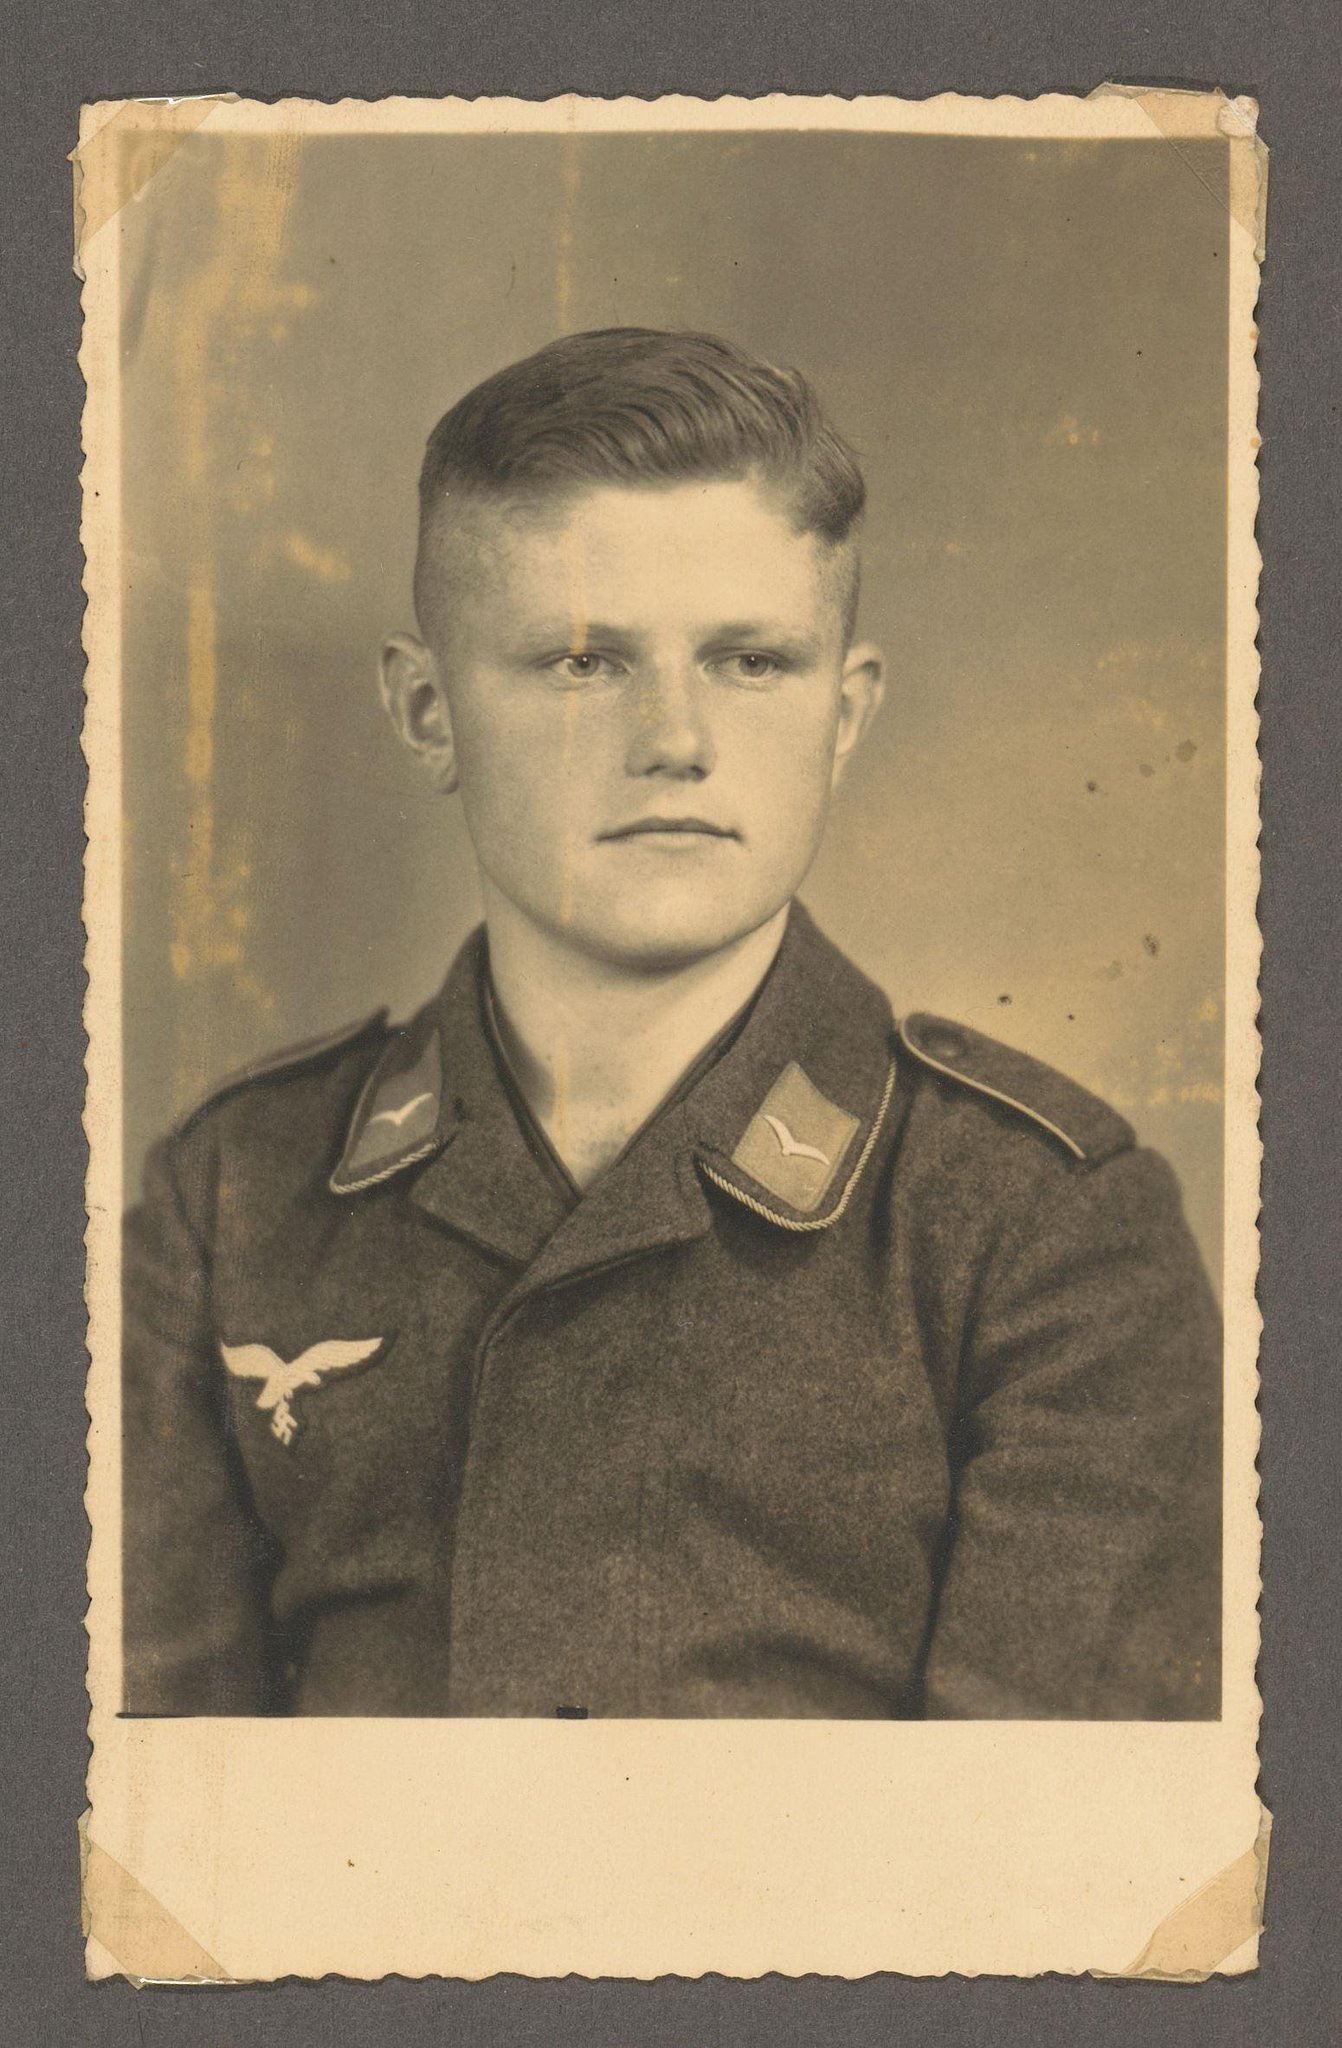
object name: album leaf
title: Portret van een militair in uniform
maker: Anonymous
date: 1941-1945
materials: paper, photographic support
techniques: gelatin silver print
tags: adult man, historical persons, the soldier; the soldier's life, (military) uniforms